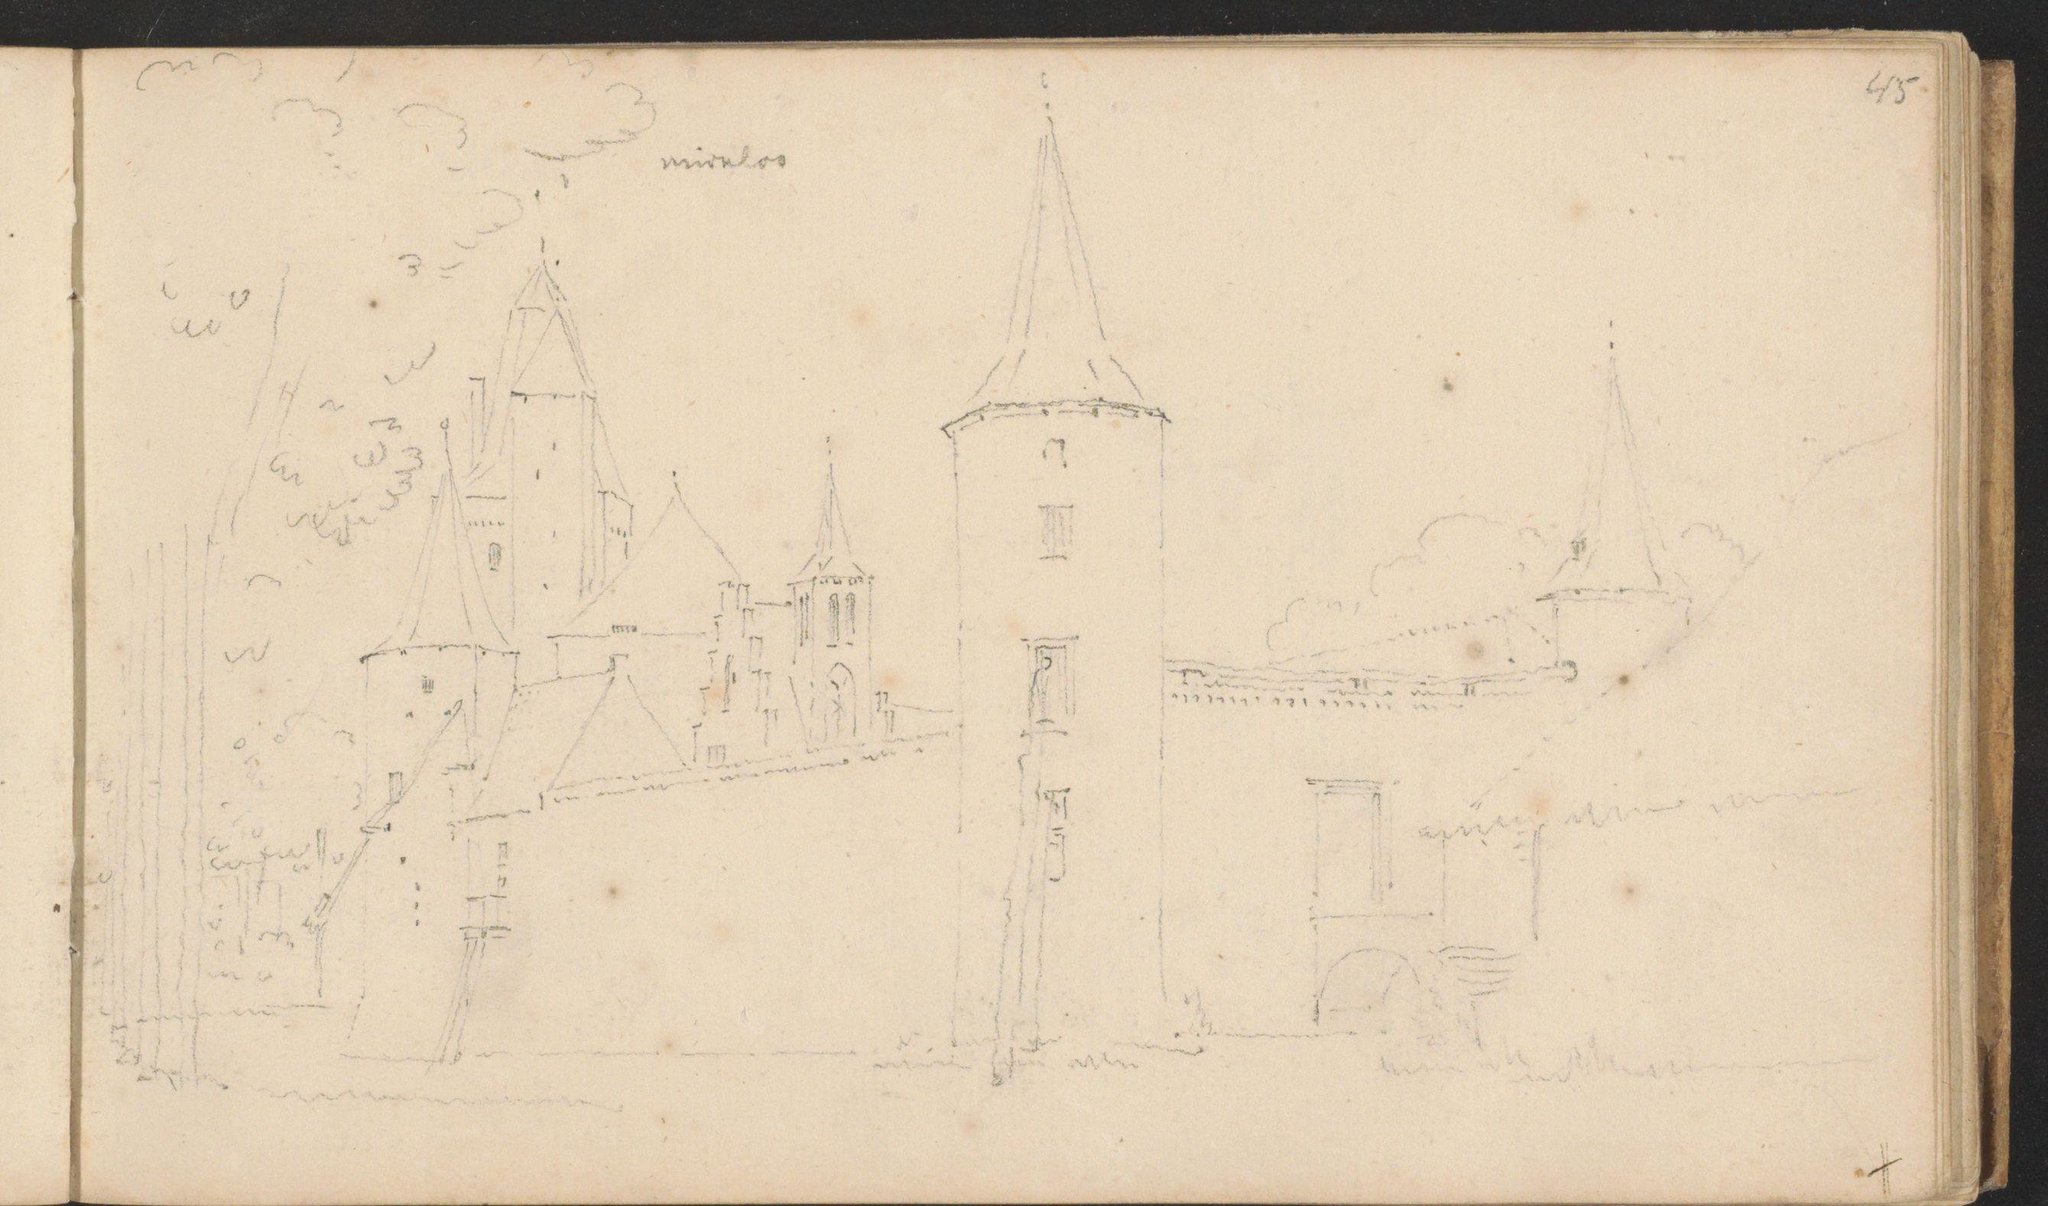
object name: sketchbook leaf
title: Kasteel Mierlo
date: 1701-1759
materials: paper, pencil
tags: castle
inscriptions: annotation: ‘mierloo’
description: Blad 45 recto uit een schetsboek met 65 bladen.